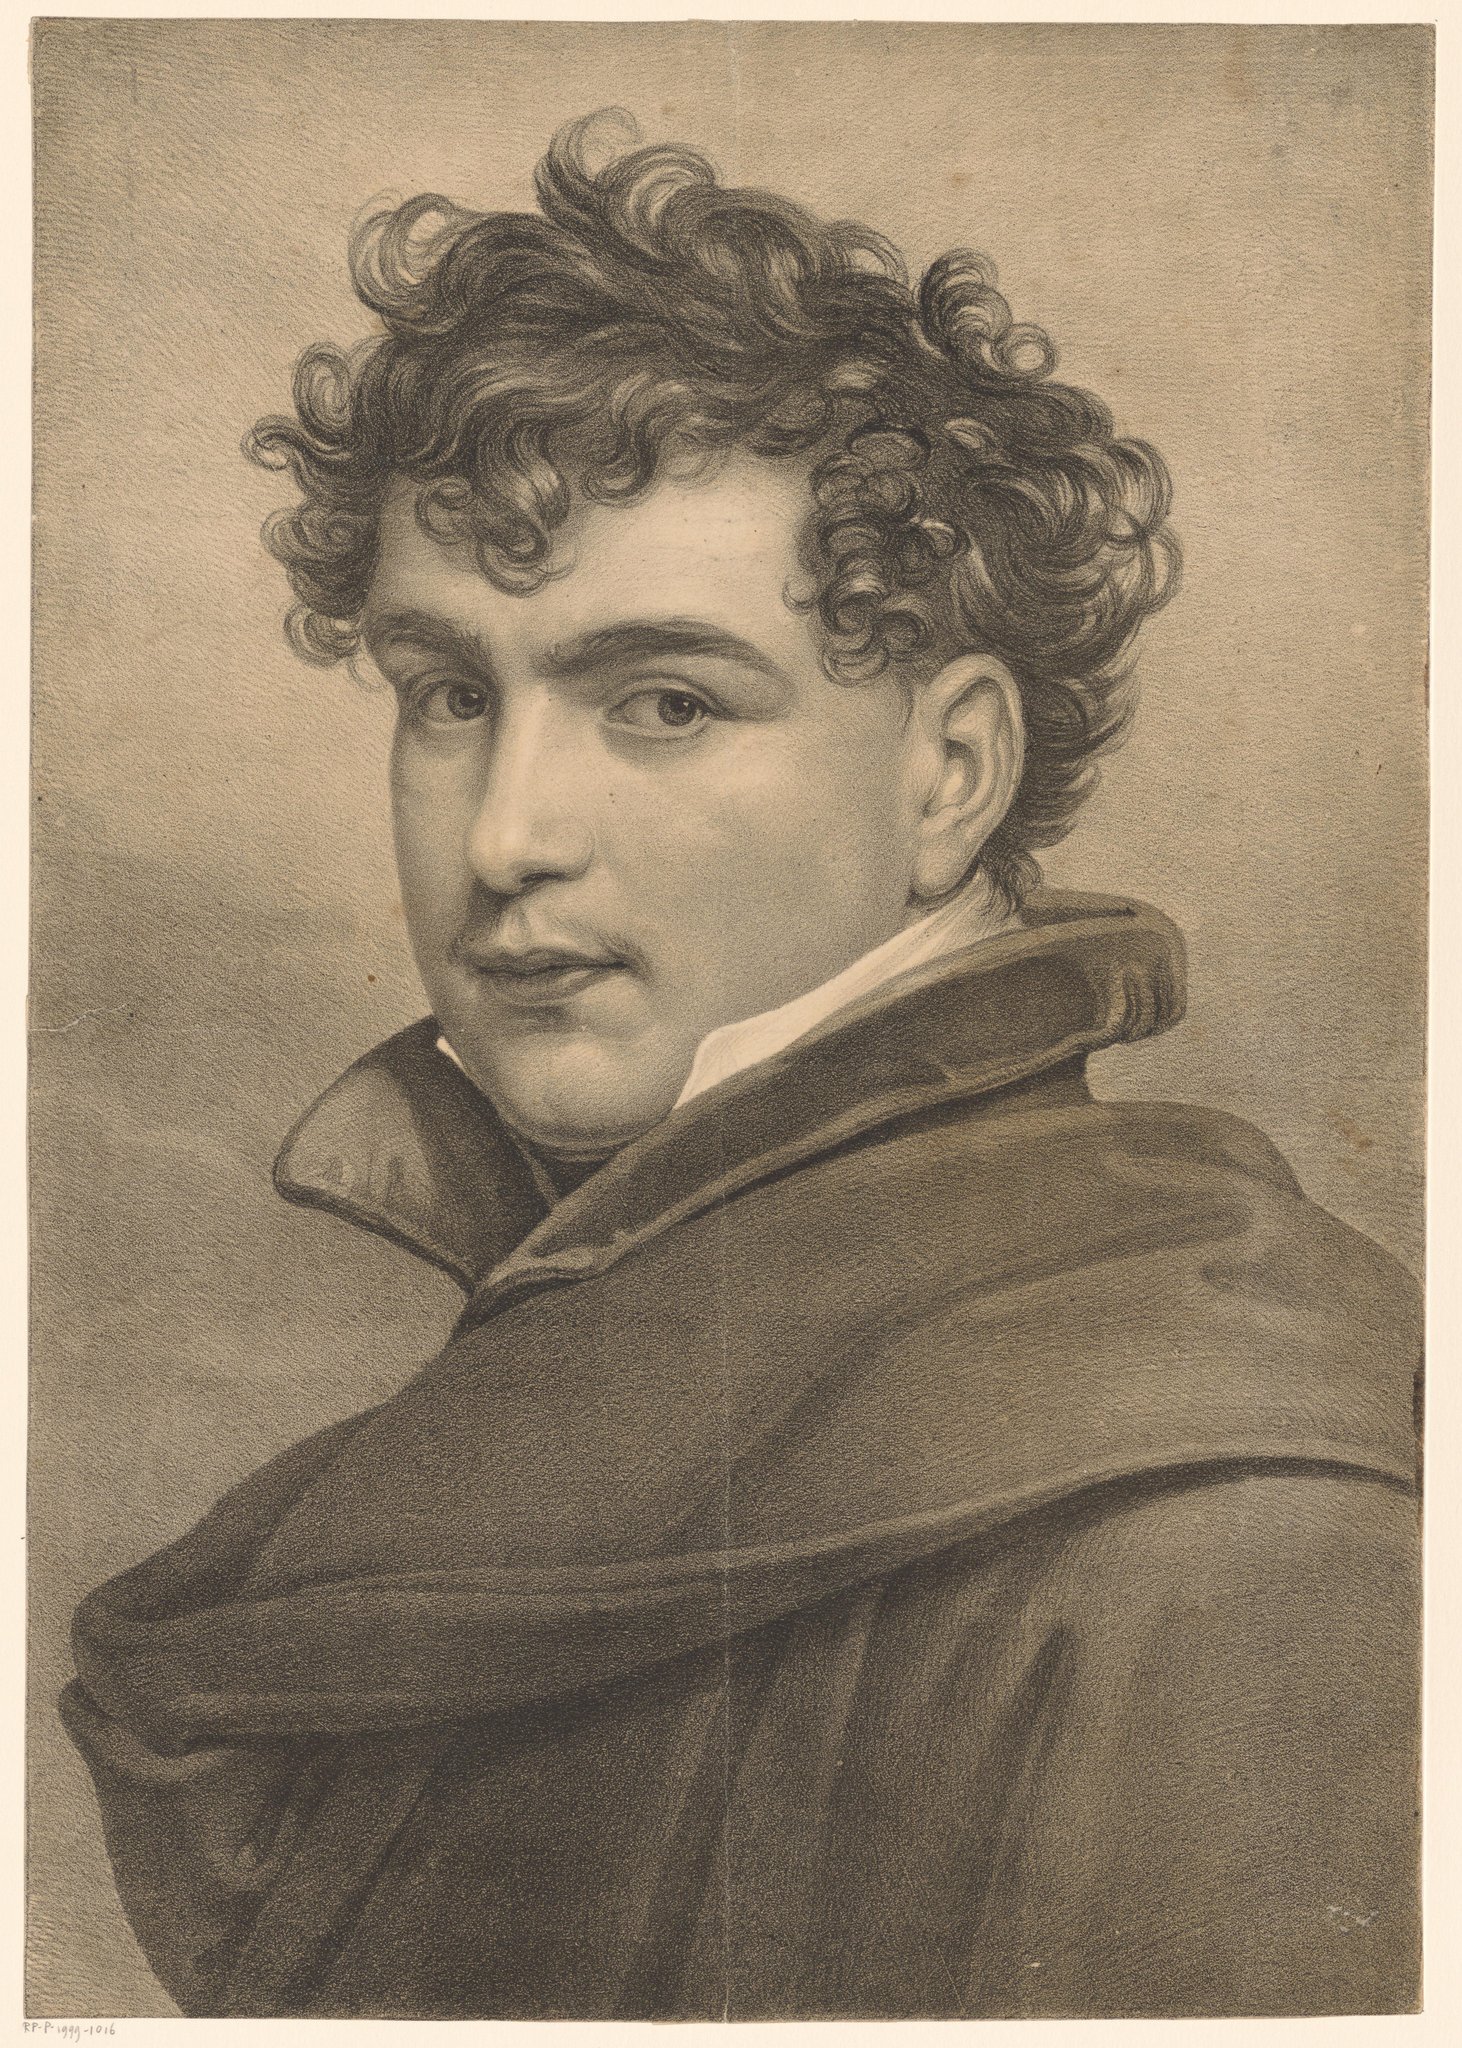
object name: print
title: Portret van Karel van Beieren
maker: Anonymous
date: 1815-1849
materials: paper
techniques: lithograph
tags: commander-in-chief, general, marshal, prince, historical persons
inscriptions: collector's mark: Lugt 2760, collector's mark: Lugt 2228